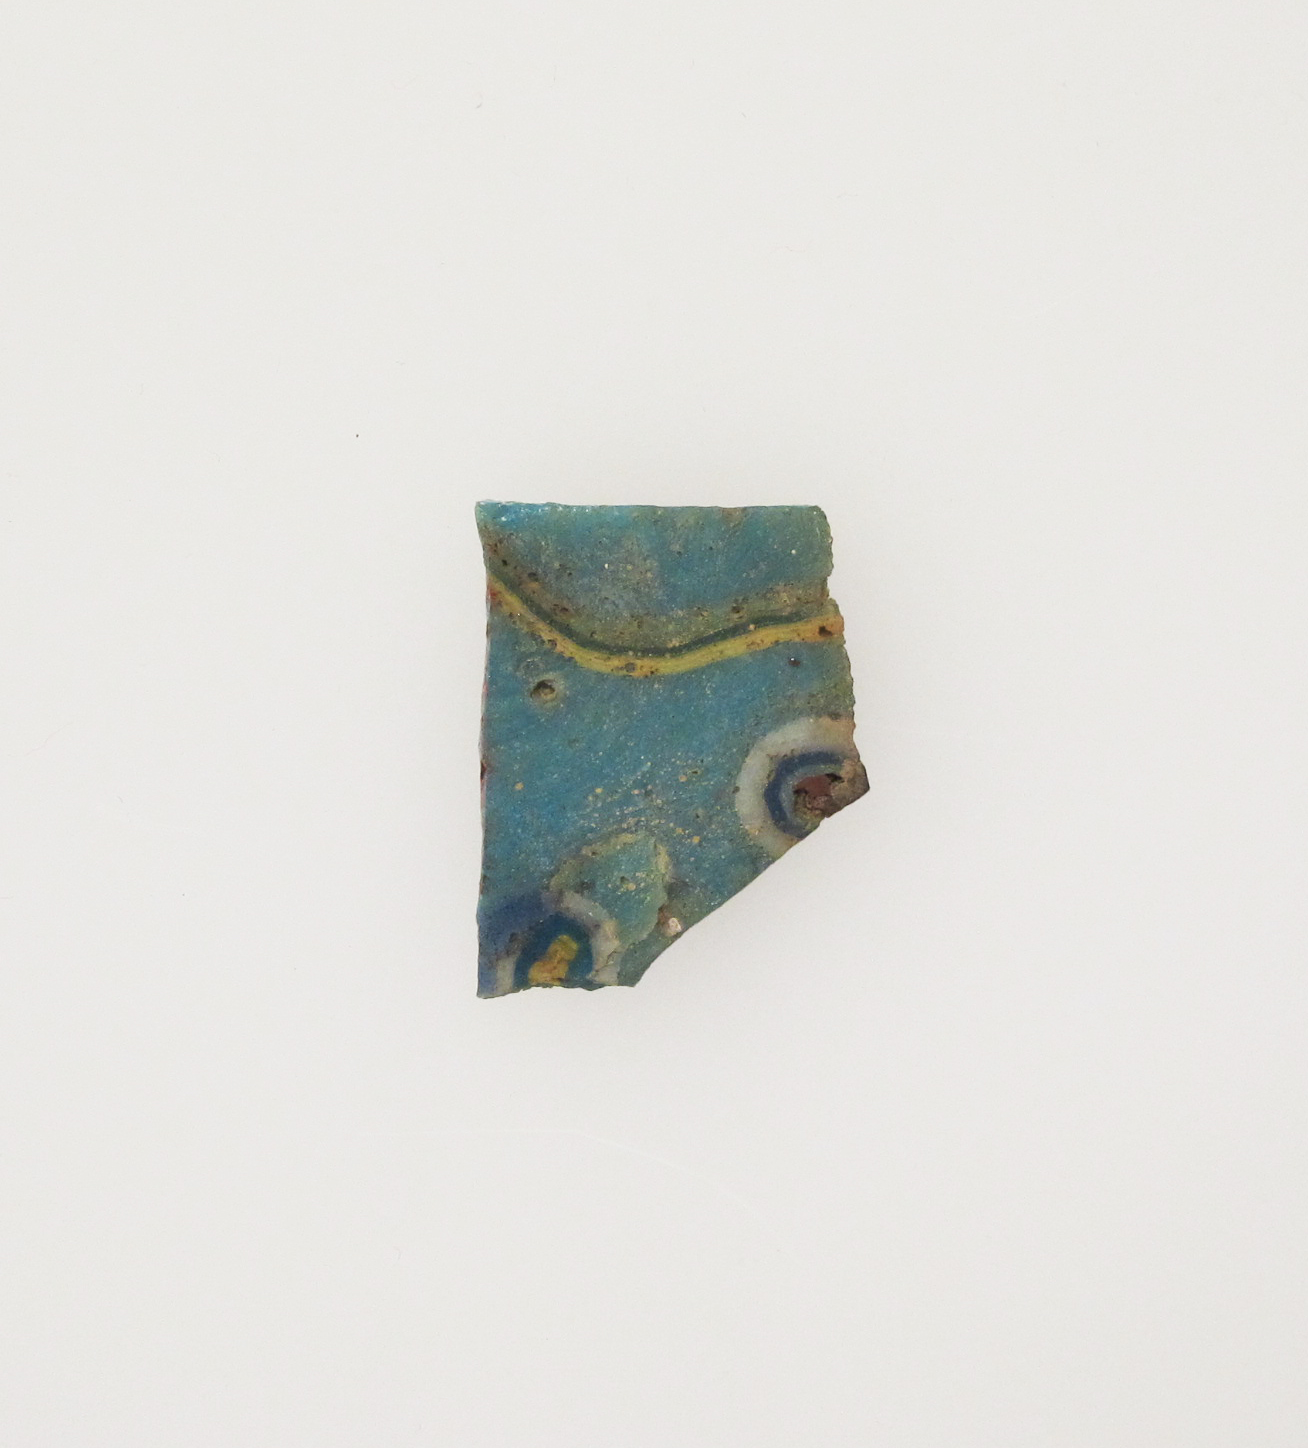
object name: mosaic block inlay fragment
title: Glass mosaic inlay fragment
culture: greek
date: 100-1 BCE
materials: glass